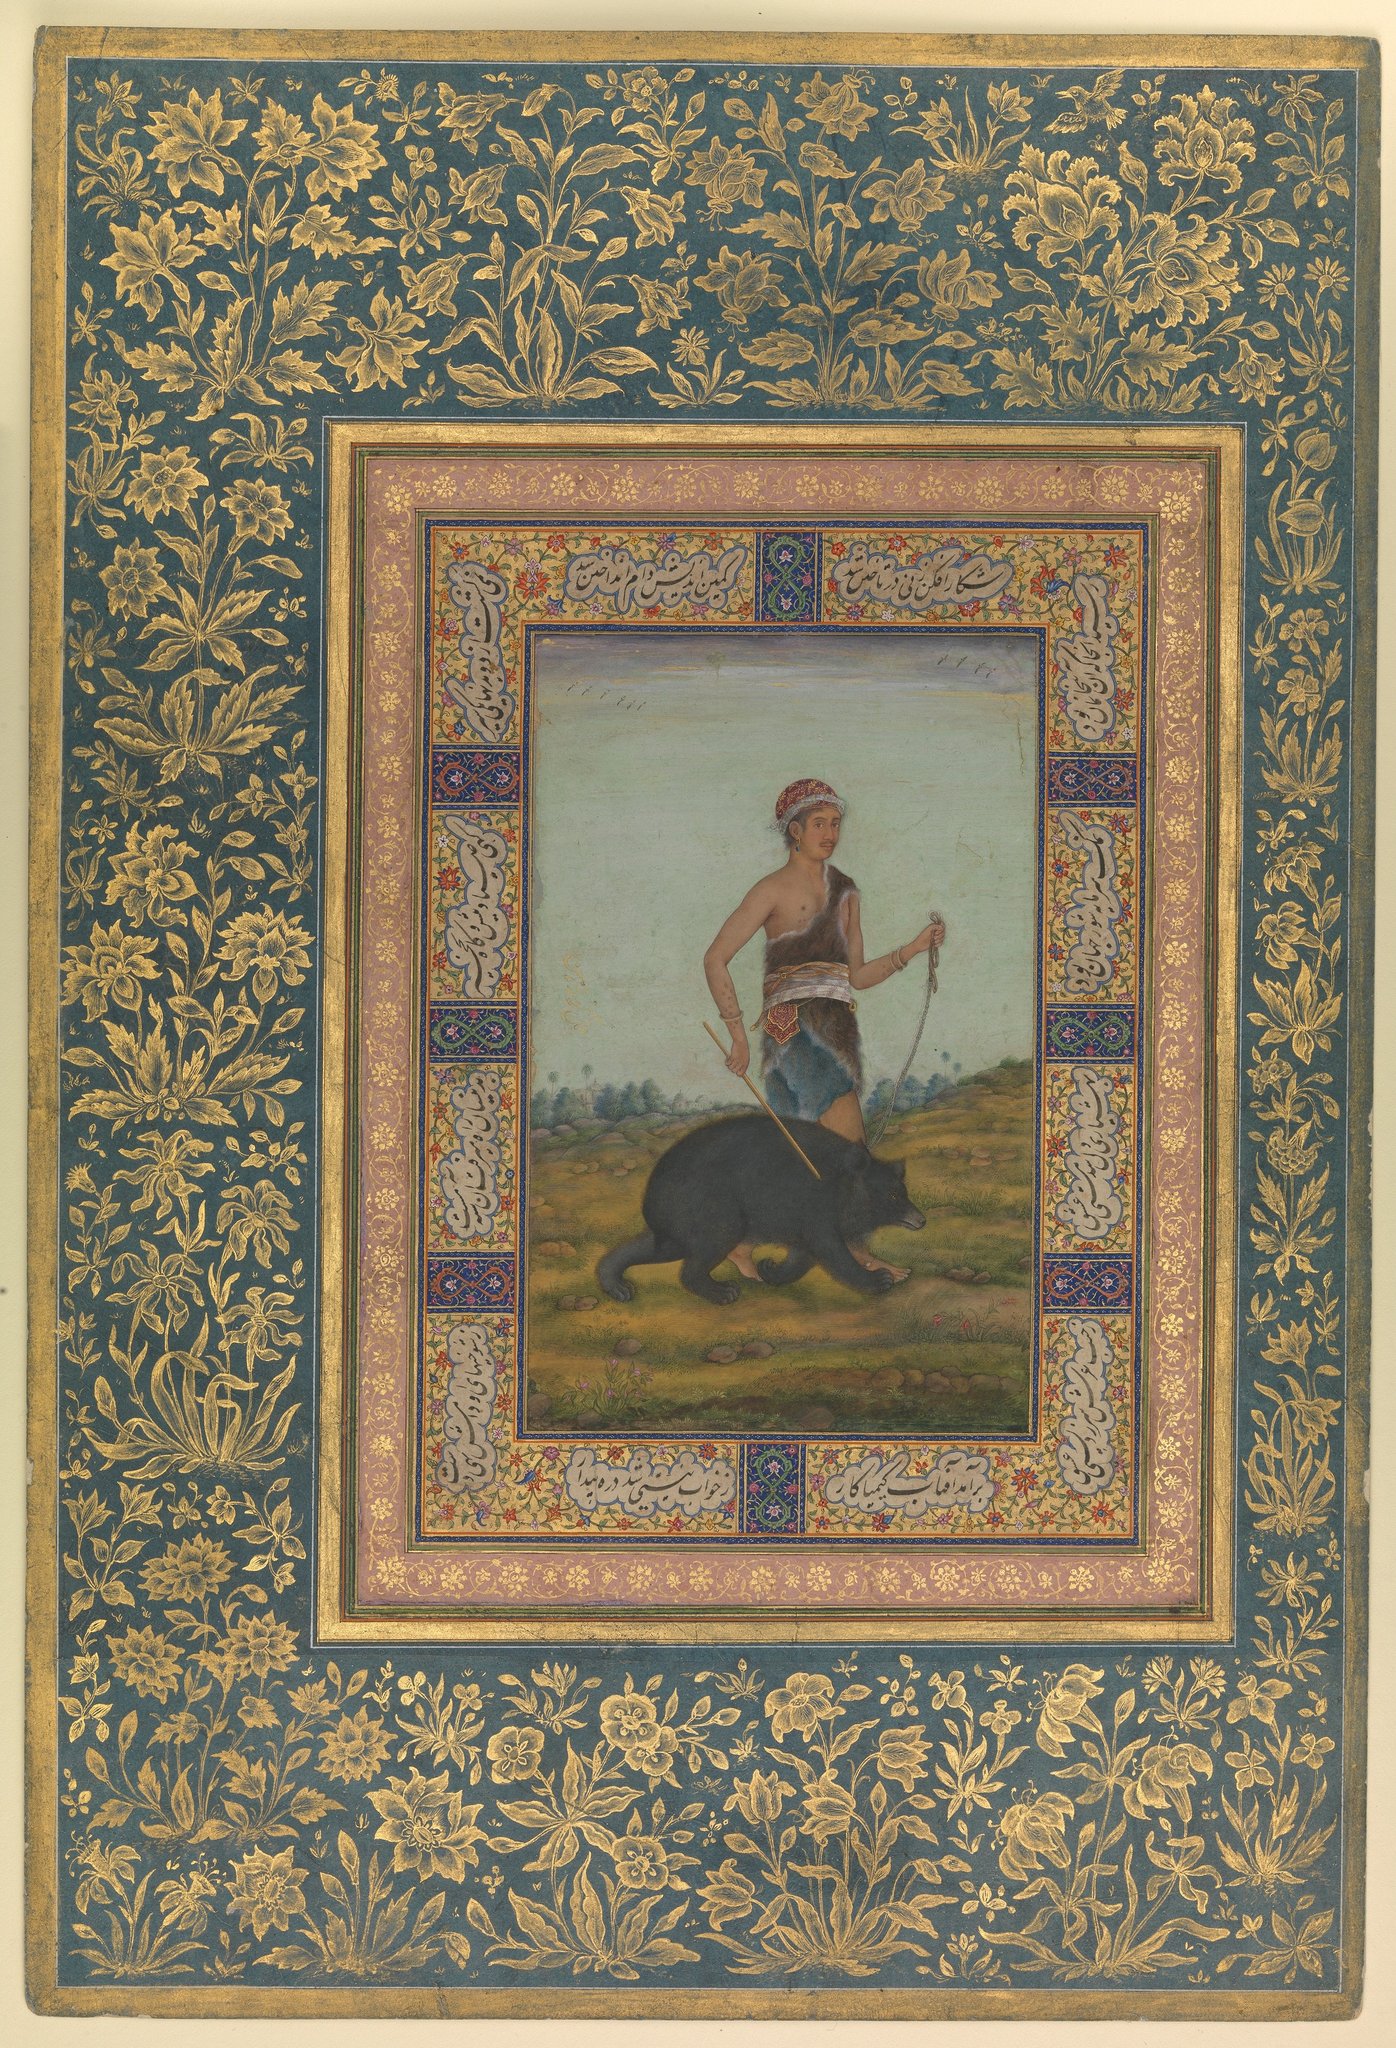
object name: album leaf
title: "Dervish Leading a Bear", Folio from the Shah Jahan Album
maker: govardhan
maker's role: artist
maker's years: 1596-1645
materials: gold, ink, paper, watercolor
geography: india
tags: bears,men,flowers